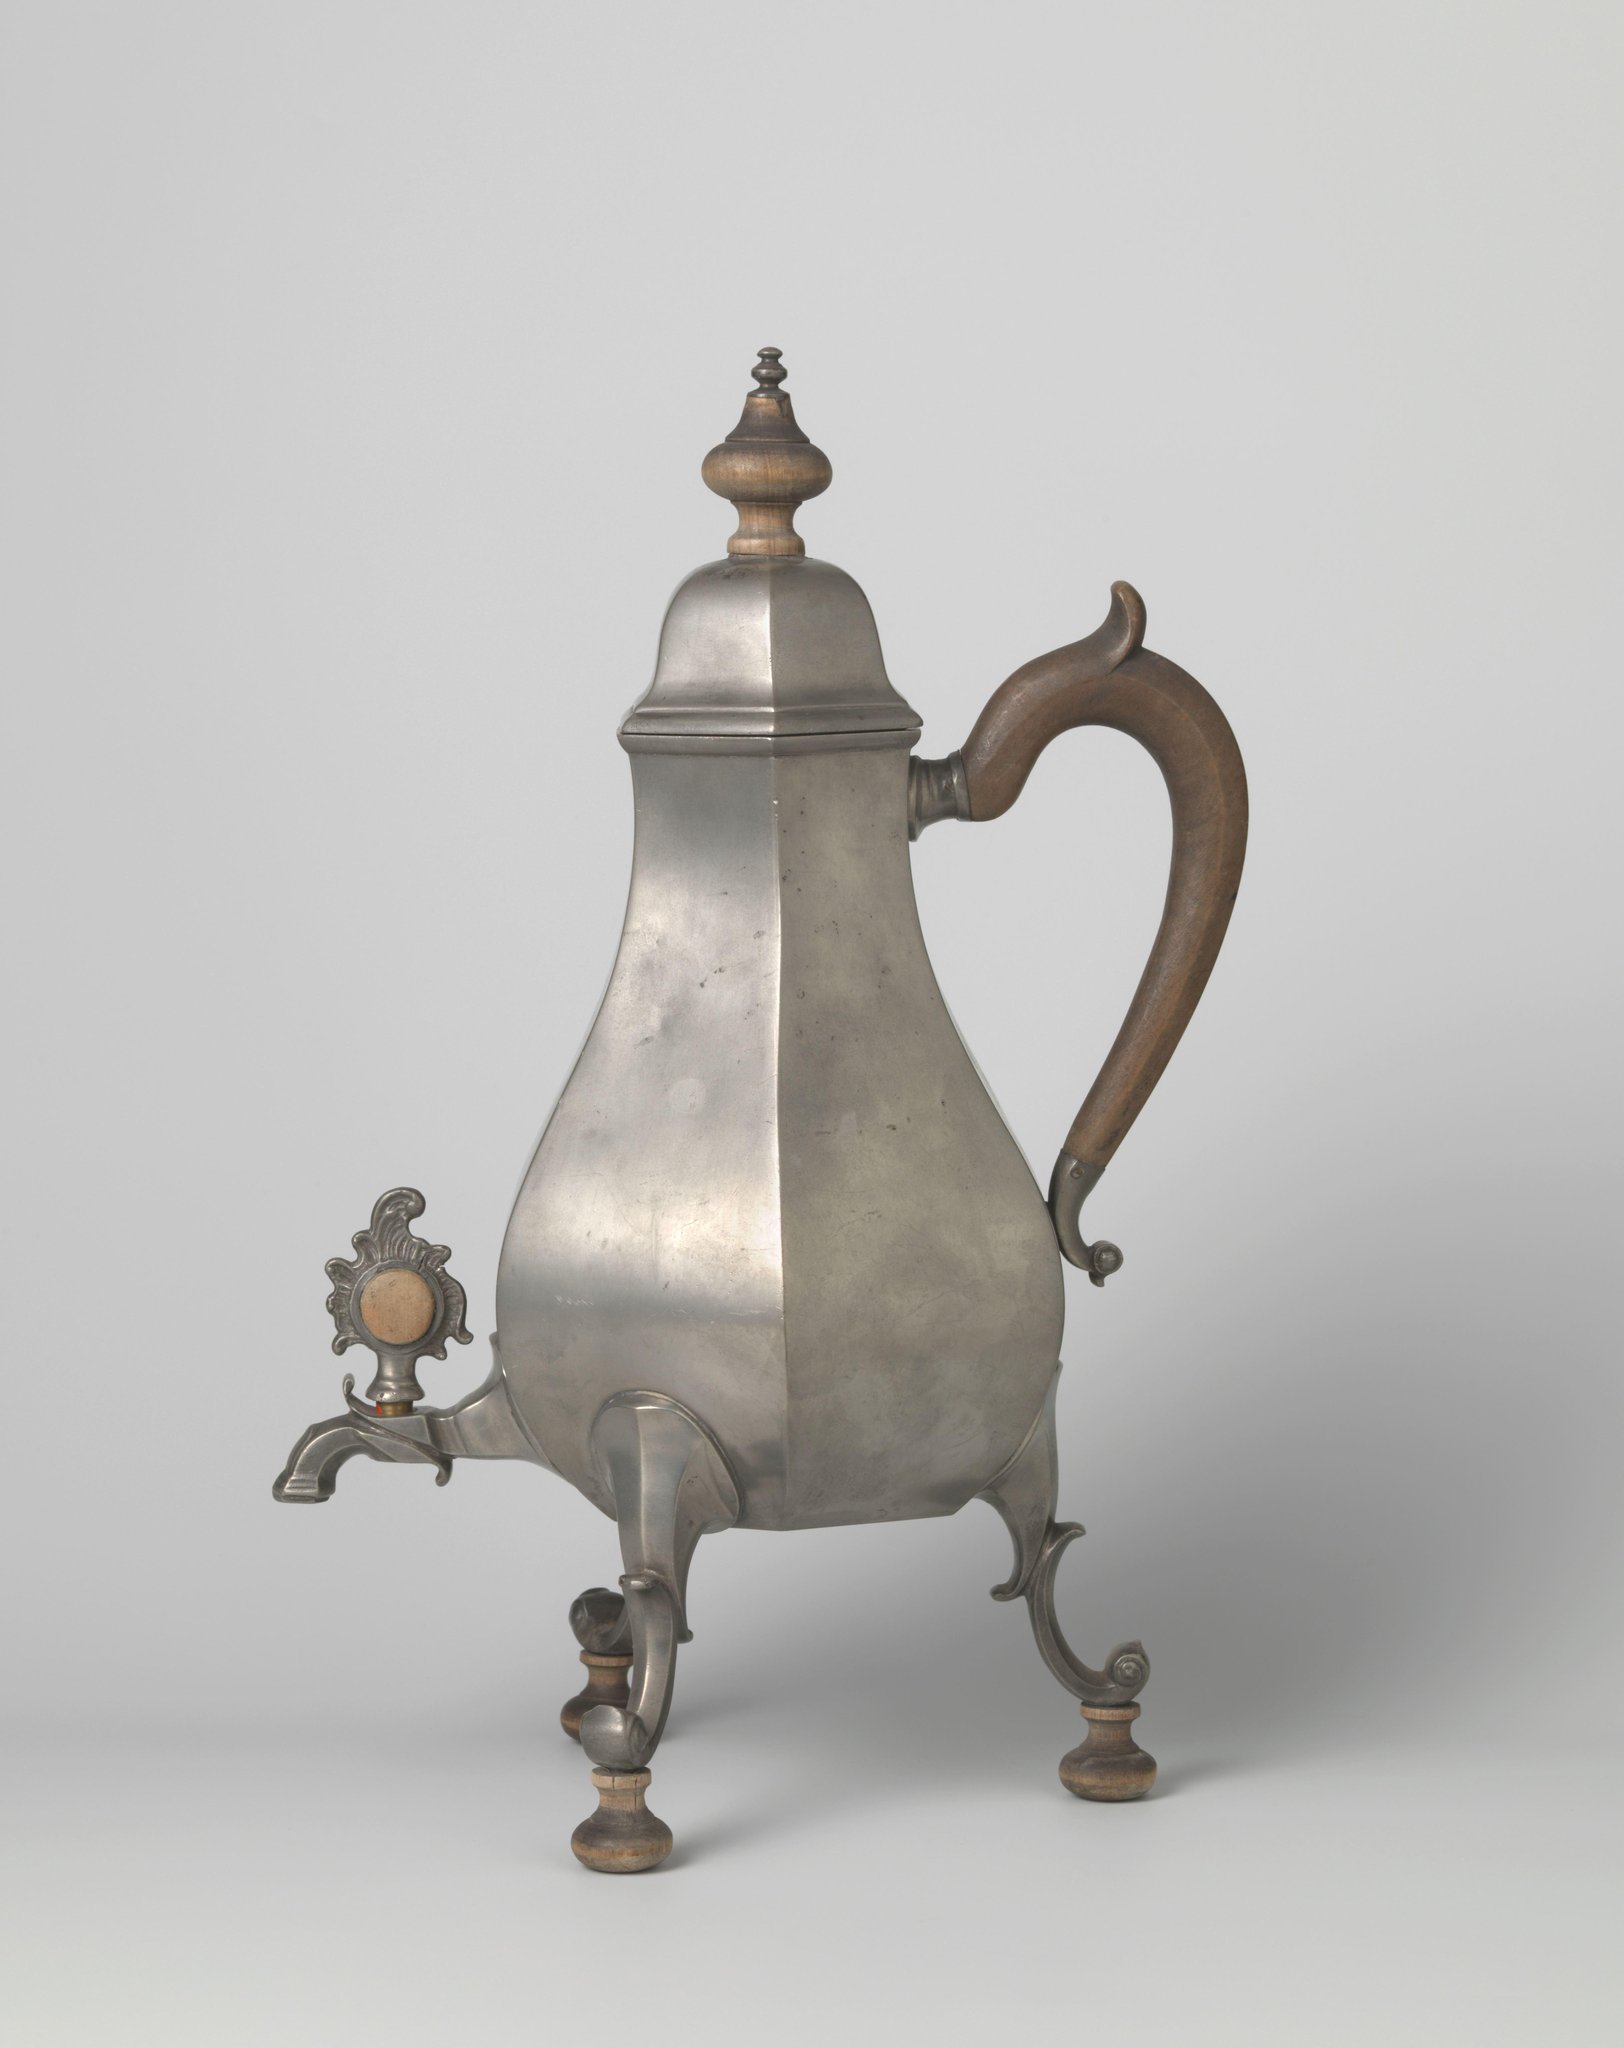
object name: coffee pot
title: Kraantjeskan van tin met deksel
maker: nicolaas kraan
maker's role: pewterers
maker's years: 1698-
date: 1720-1750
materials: tin, wood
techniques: casting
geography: amsterdam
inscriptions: quality mark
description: Koffiekan van tin, een zogenaamde kraantjeskan. De poten zijn gevormd door voluten en rusten op houten bollen. Daarboven is de peervormige, zeshoekige kan. Net onder de liprand is het handvat aangebracht, dat doorloopt tot aan het breedste punt van de kan en deels van hout is. Onderaan de buik is het kraantje. Het losse deksel is zeshoekig met een houten knop.